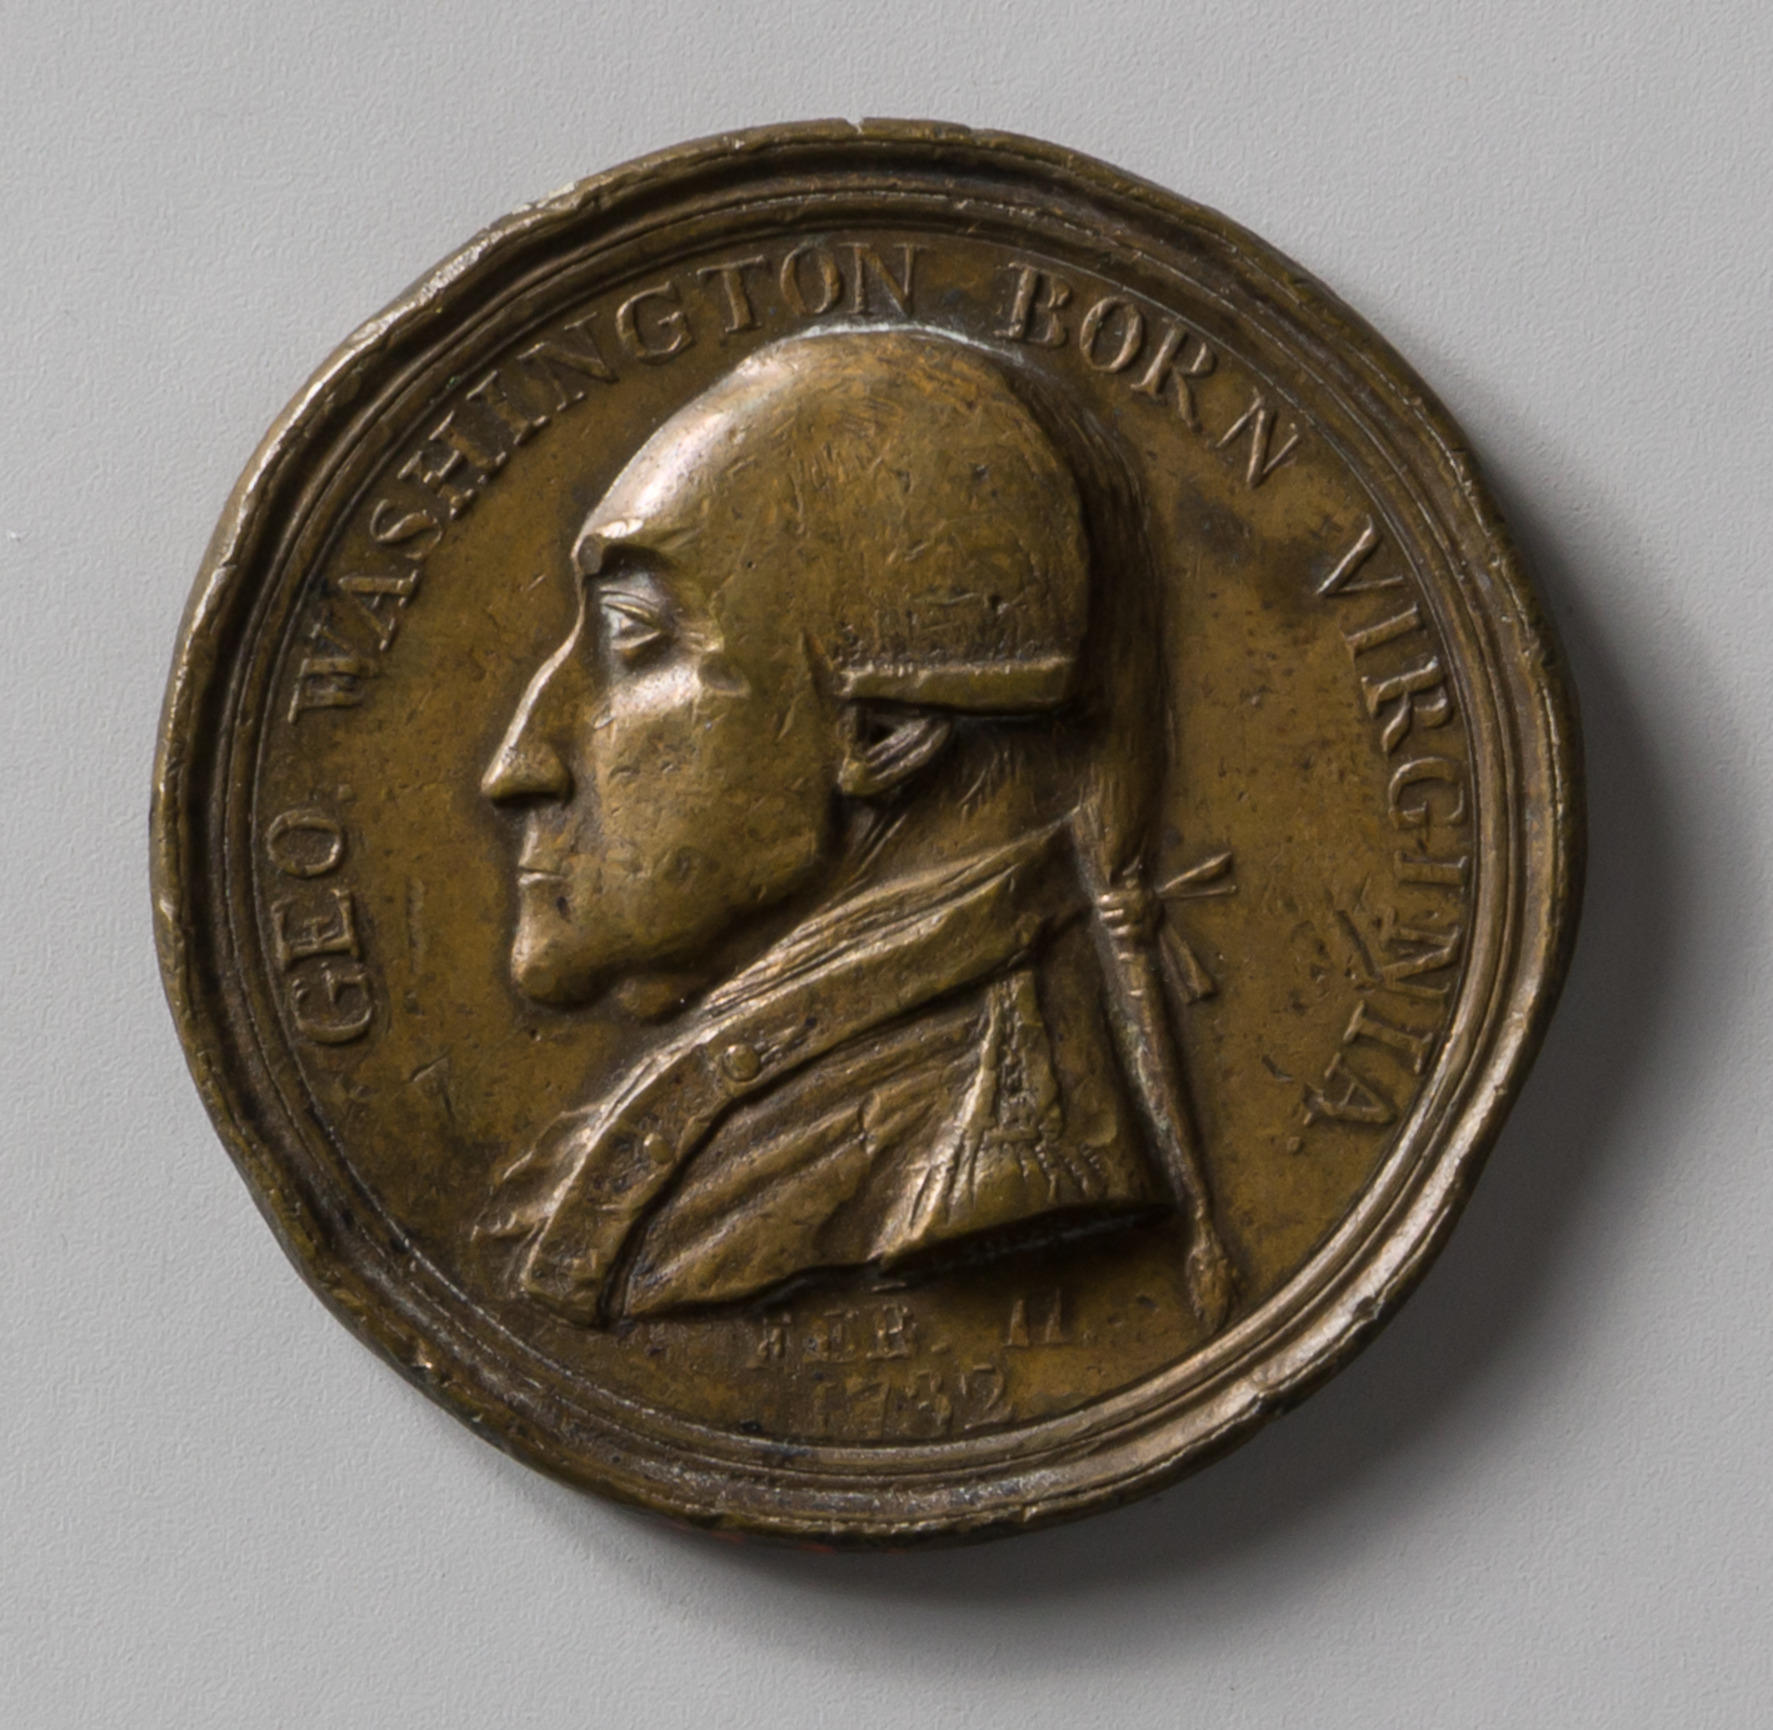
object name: medal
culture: american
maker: james manley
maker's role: maker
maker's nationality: american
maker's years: 1790-1800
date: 1790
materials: gilt bronze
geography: united states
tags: george washington,profiles